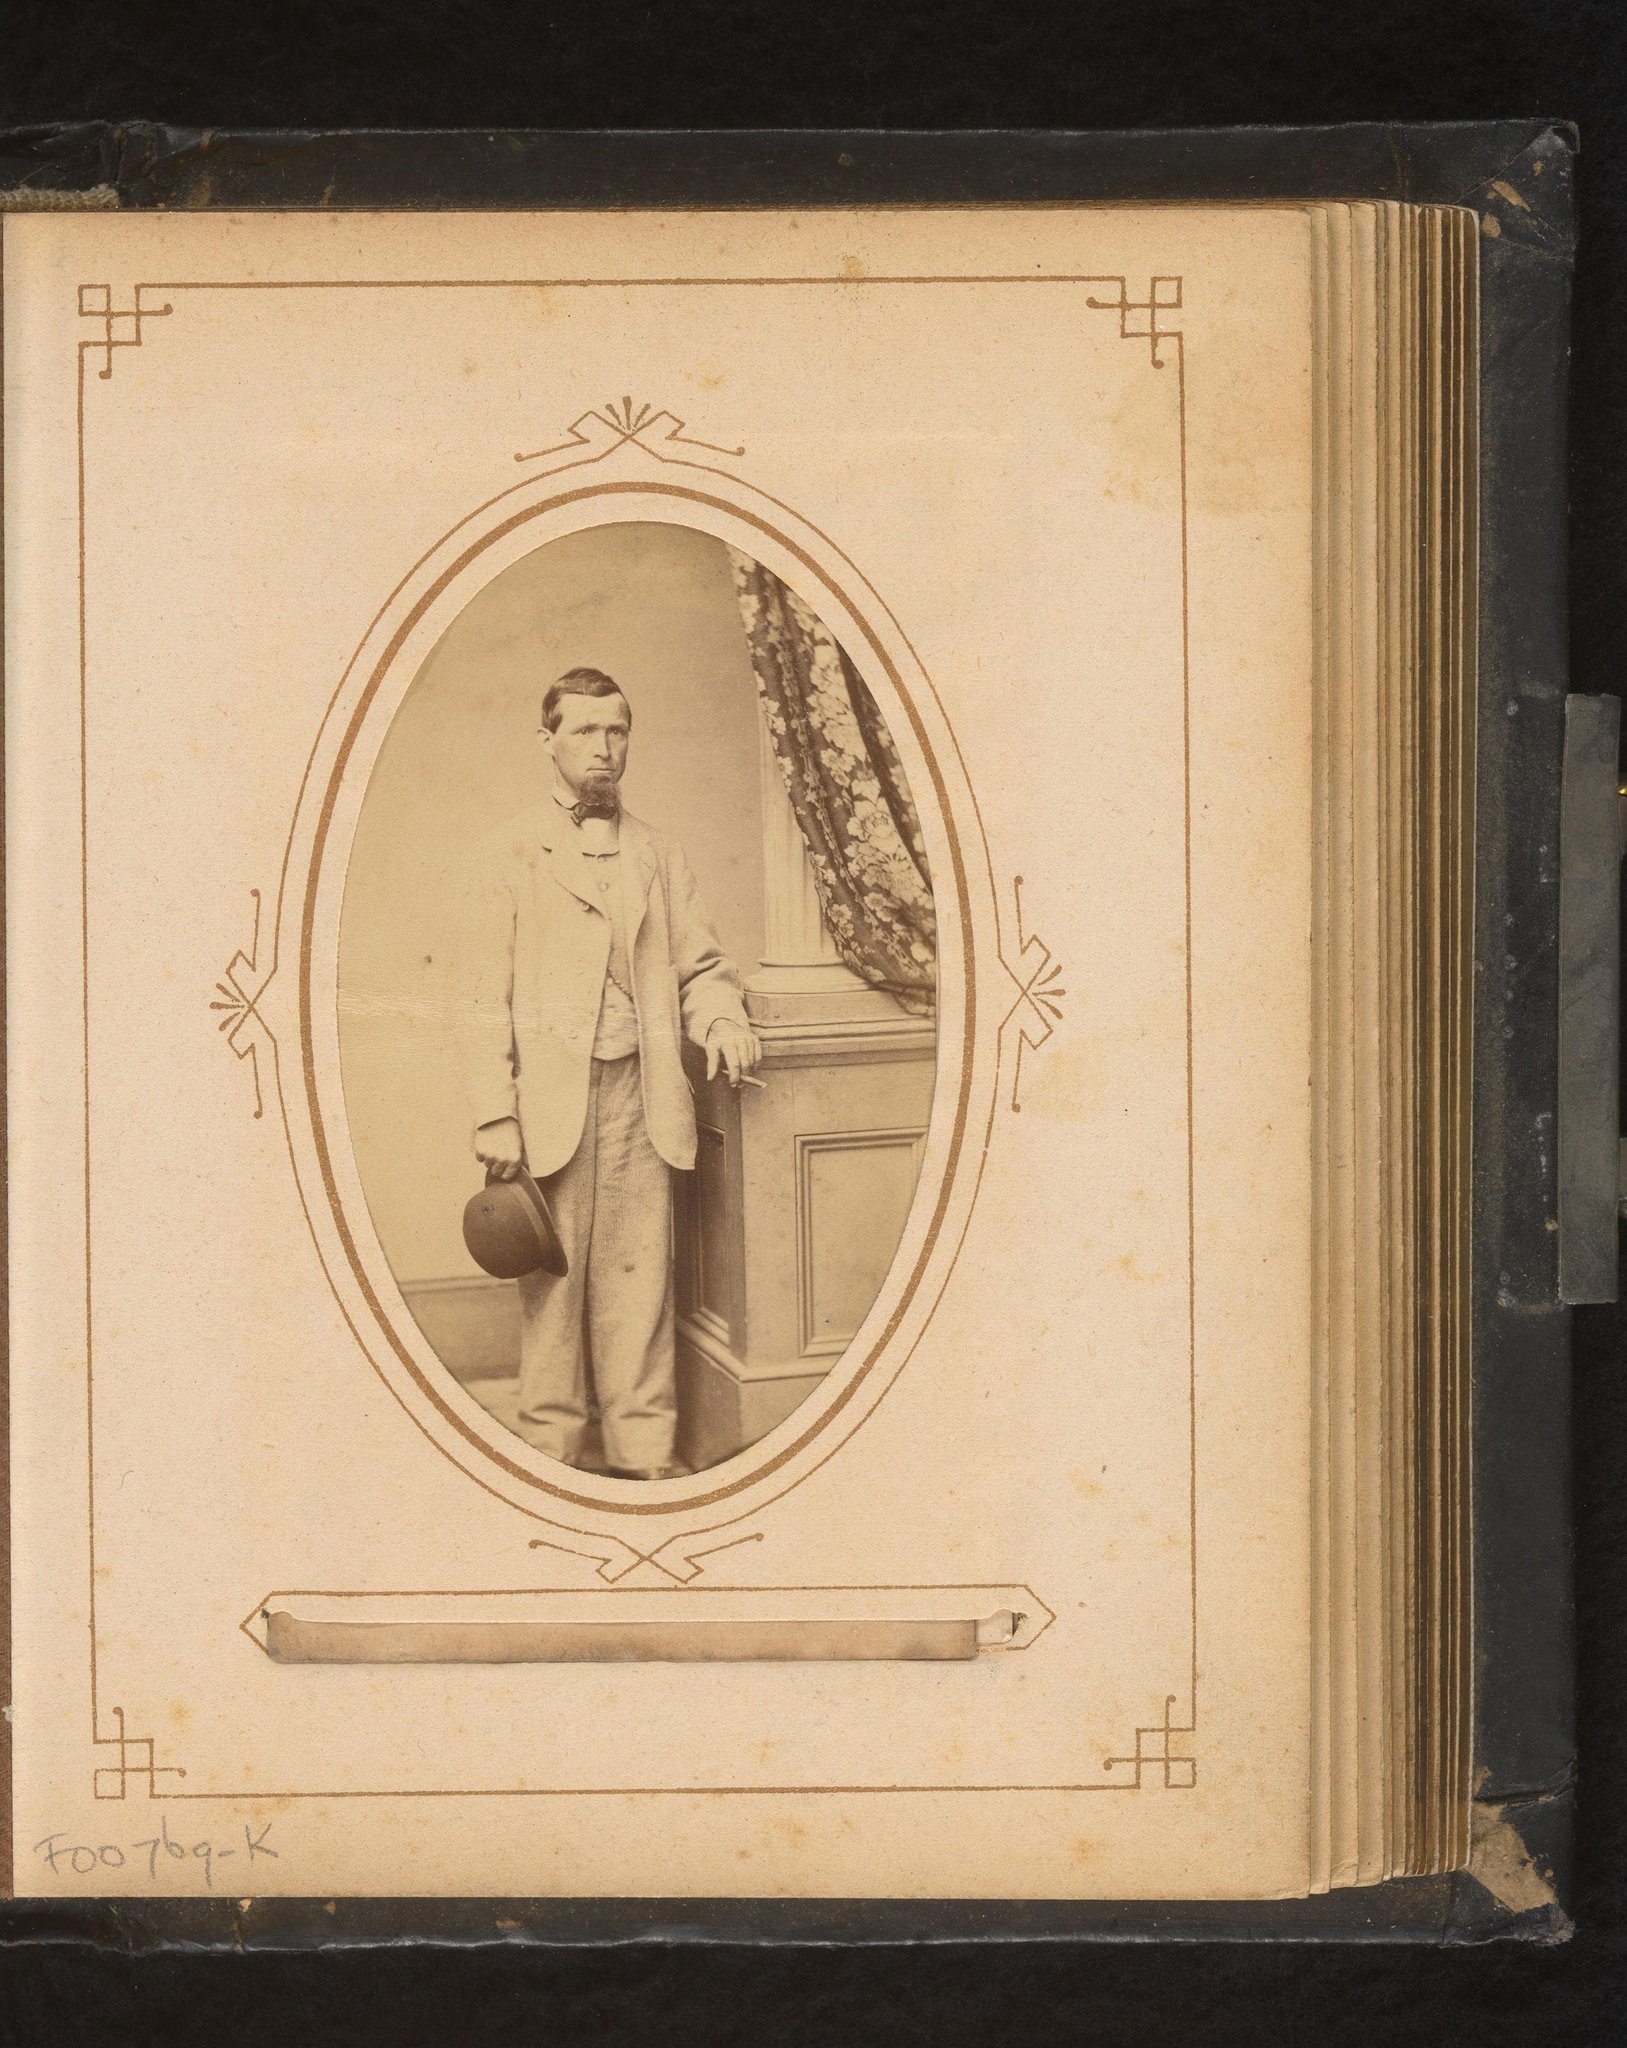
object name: carte de visite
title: Portret van een staande man met bolhoed en sigaar in handen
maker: g.d. wise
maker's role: fotograaf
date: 1870-1900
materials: cardboard, photographic support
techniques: albumen print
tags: cigar, head-gear: bowler hat, adult man, historical persons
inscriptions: inscription: ‘G.D. Wise/ Photographer,/ N.W. Cor./ Second and Christian,/ Philadelphia/ No. (...)’